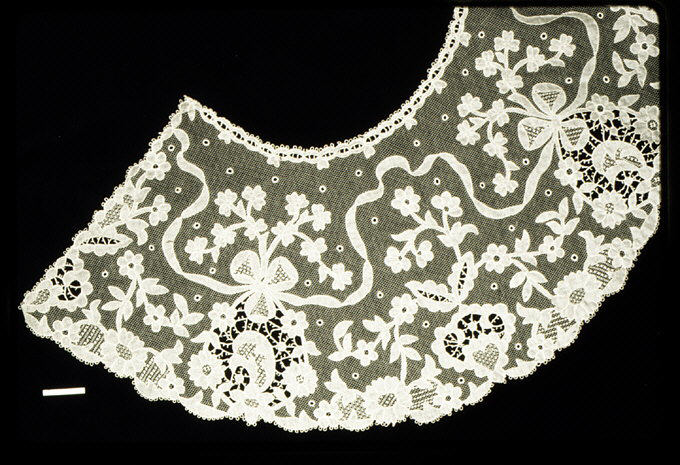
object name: collar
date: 1867-1900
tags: flowers